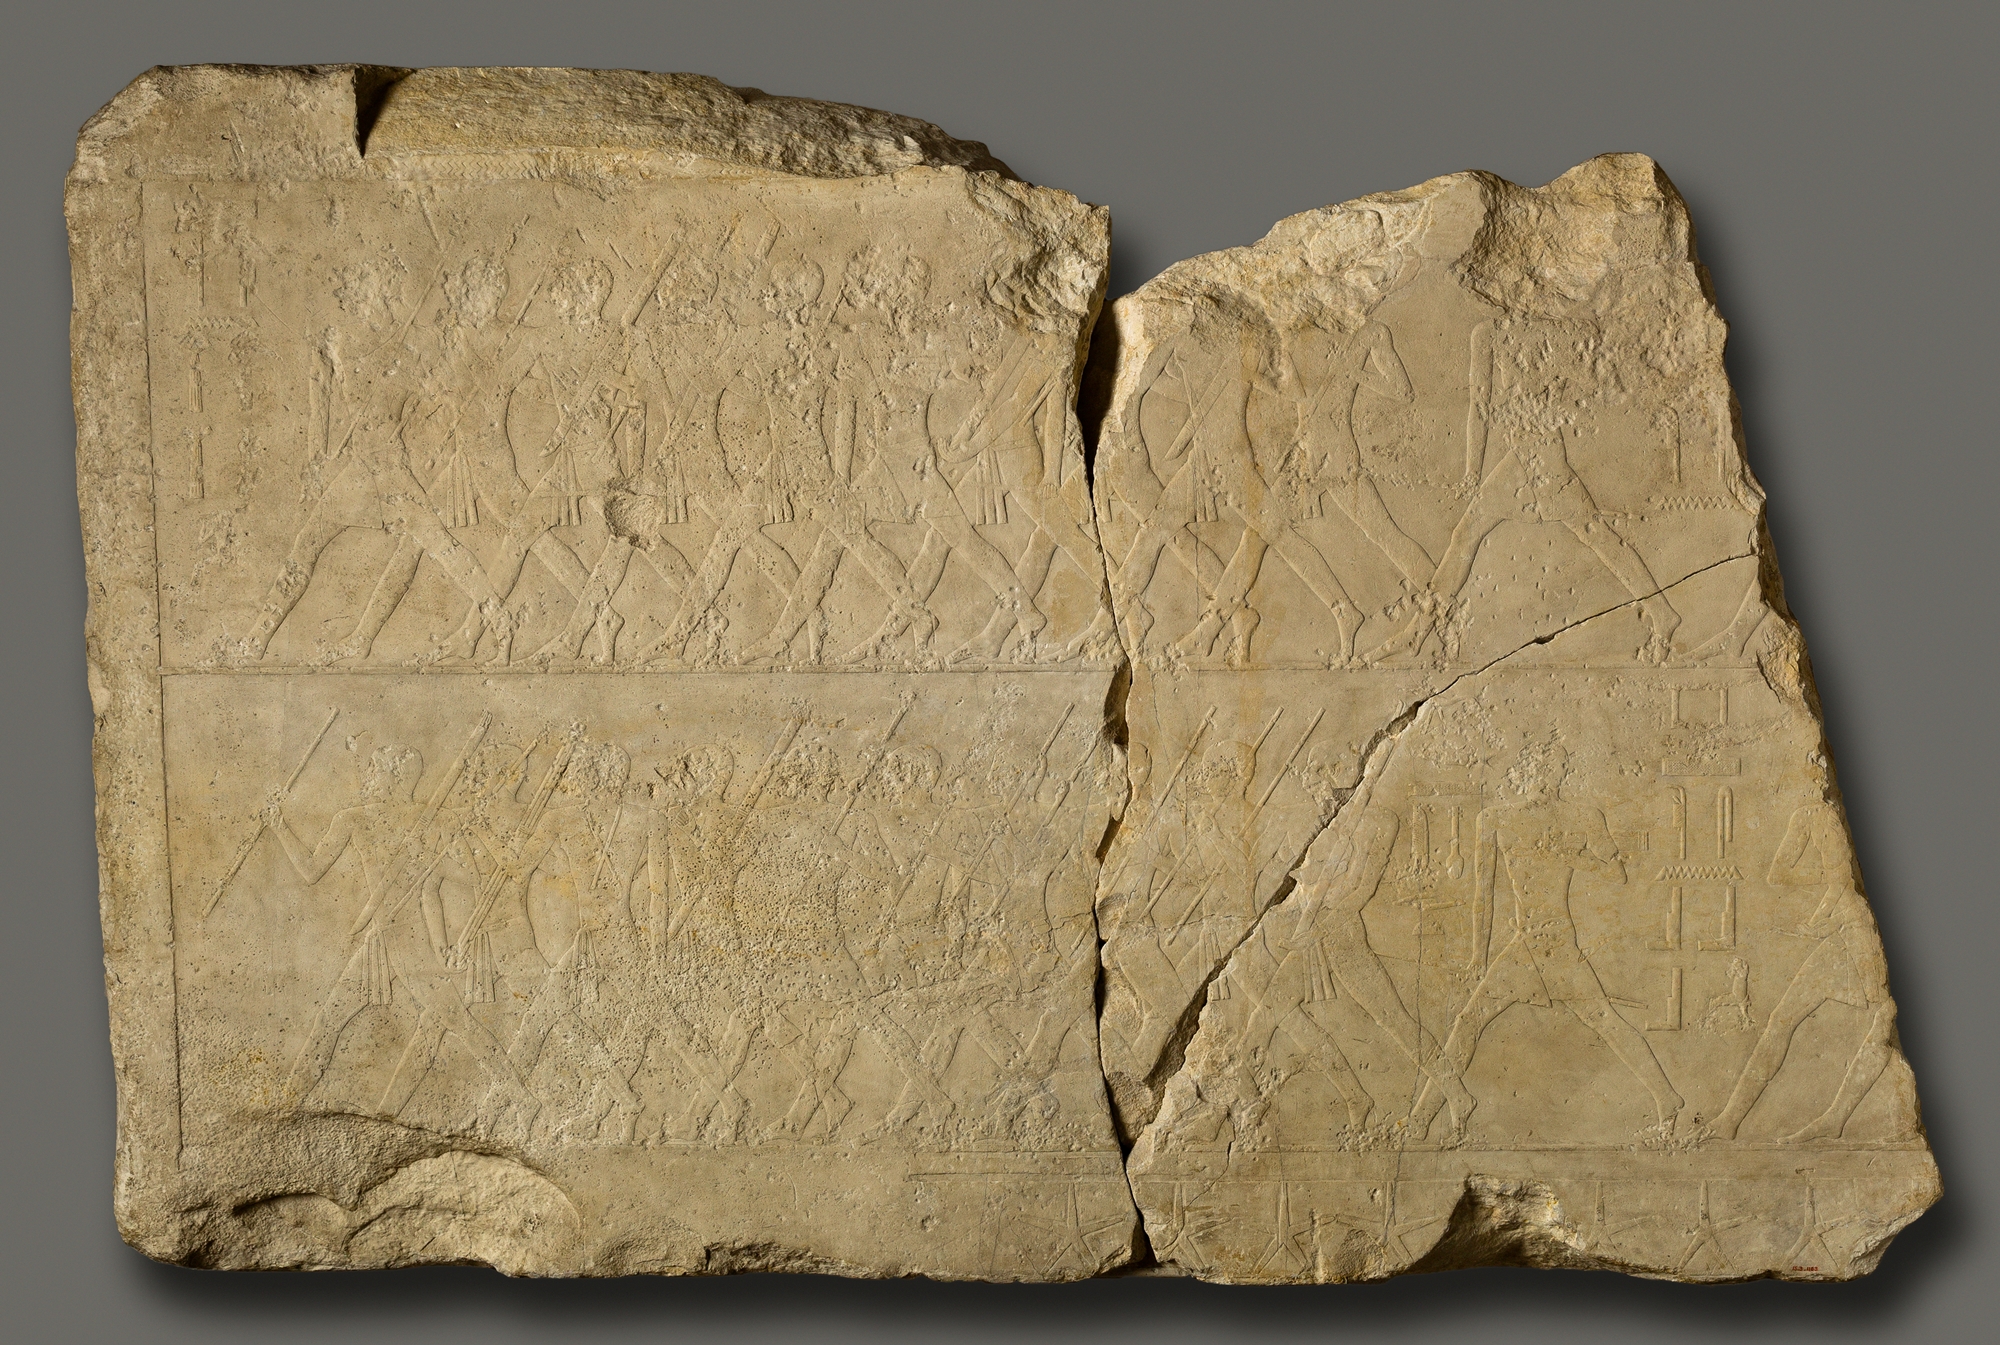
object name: relief, running troop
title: Relief with running troops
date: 2465-2458 BCE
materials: limestone, paint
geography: egypt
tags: soldiers,men